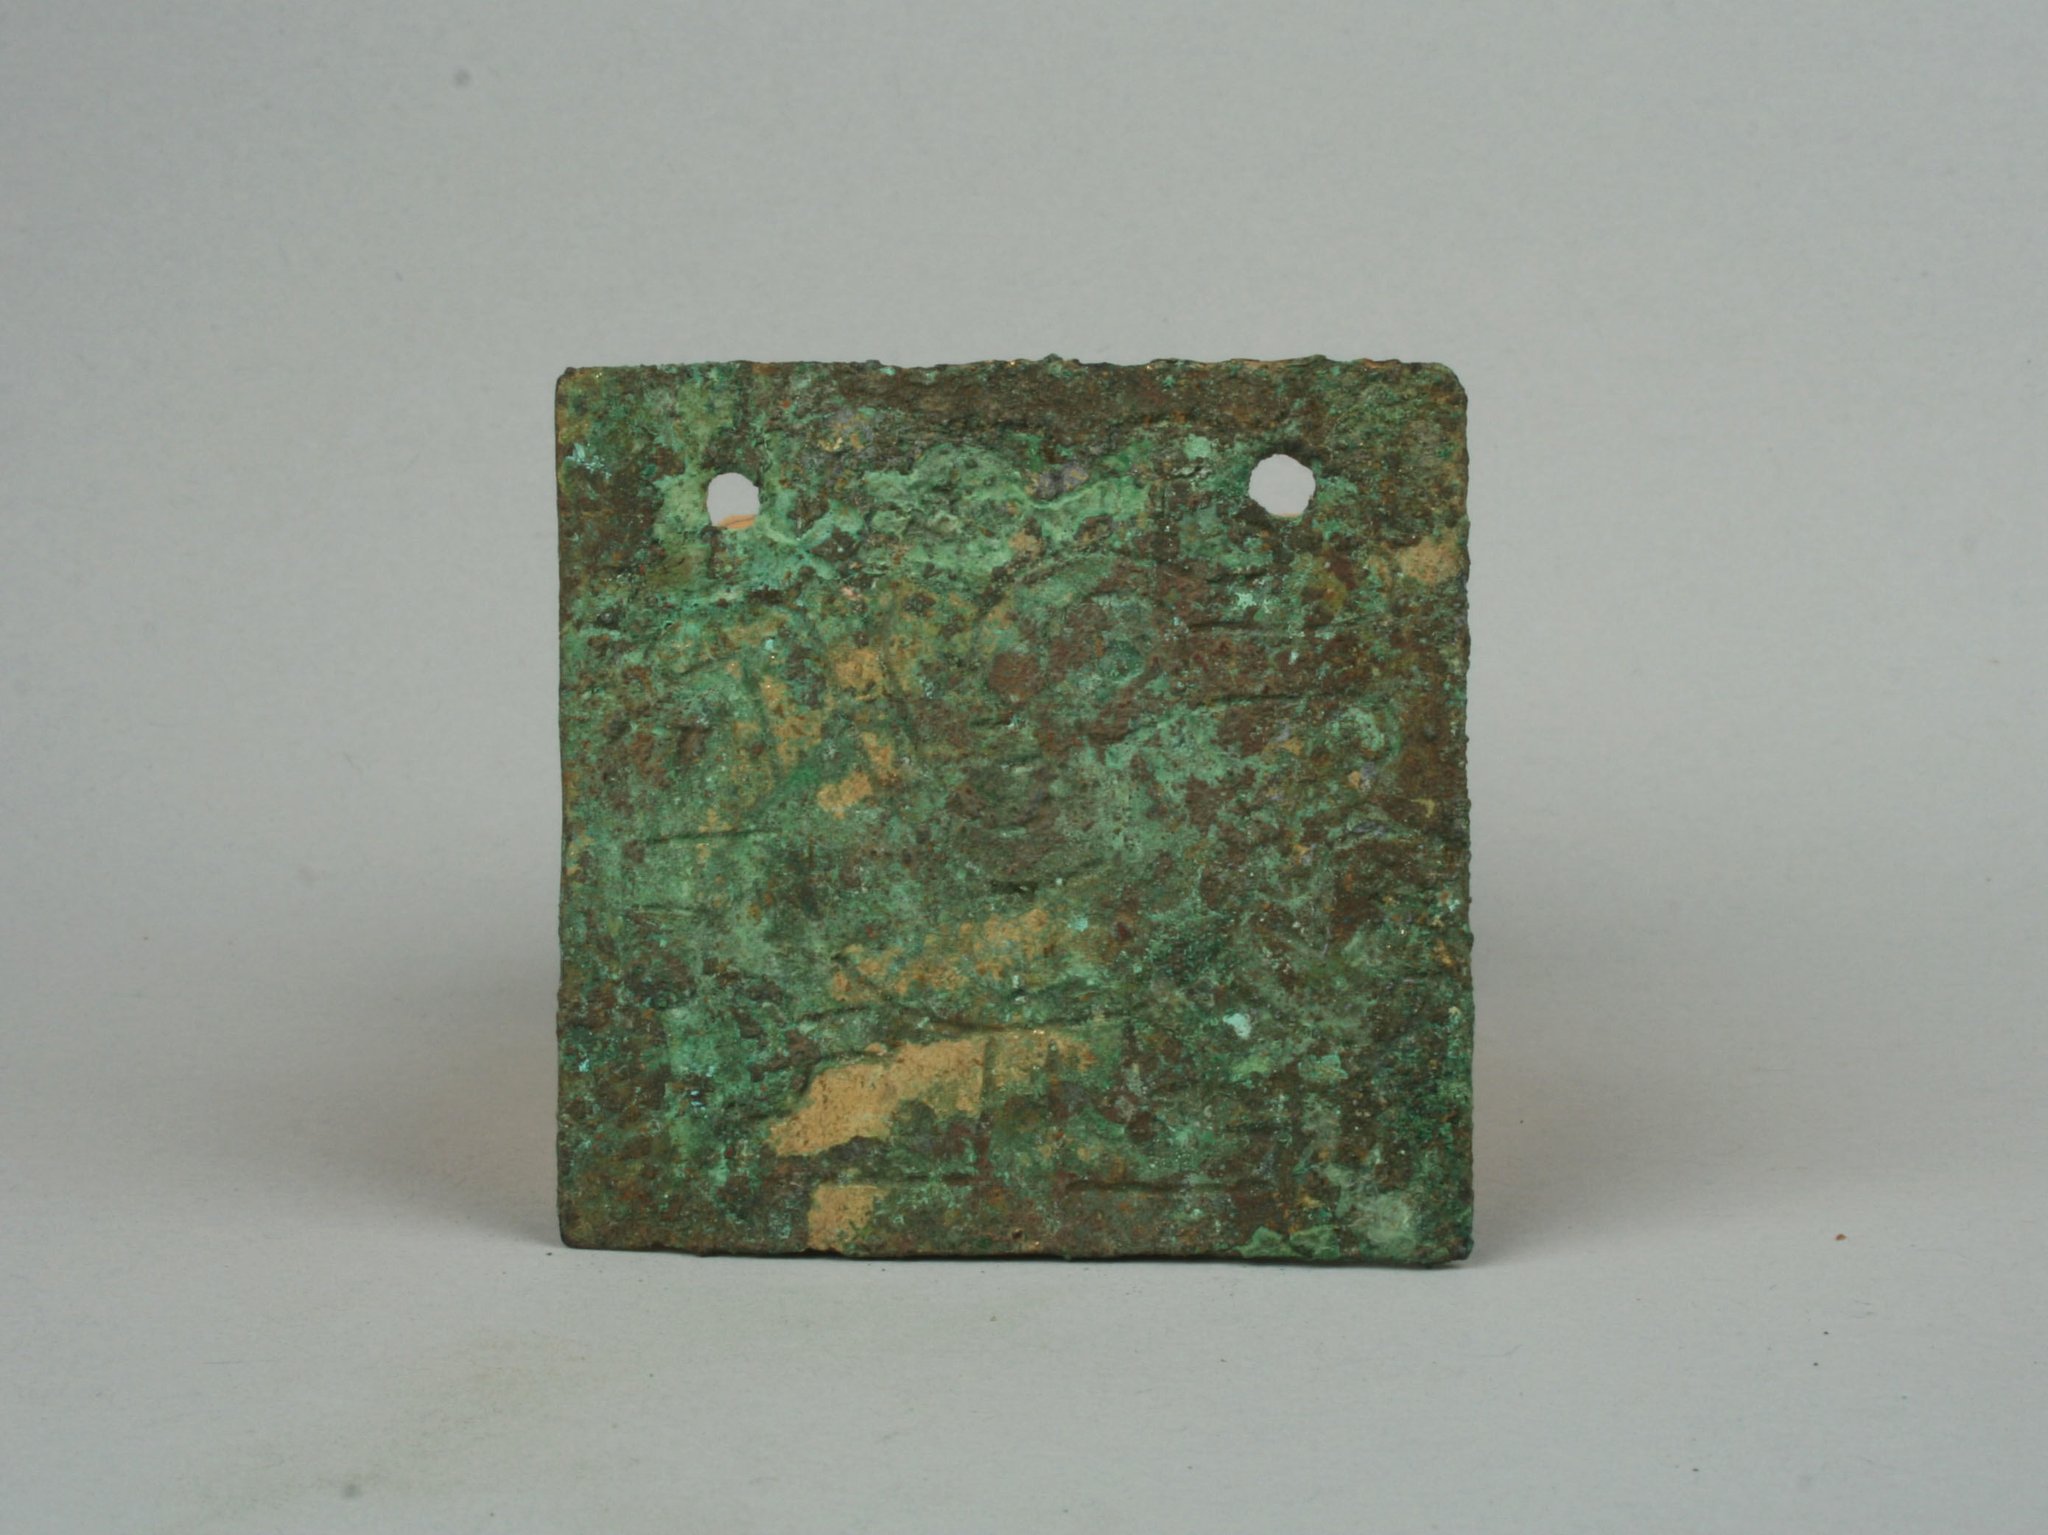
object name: ornament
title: Bird Plaque Ornament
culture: vicús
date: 300 BCE-200 CE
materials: copper, gilt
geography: peru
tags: birds